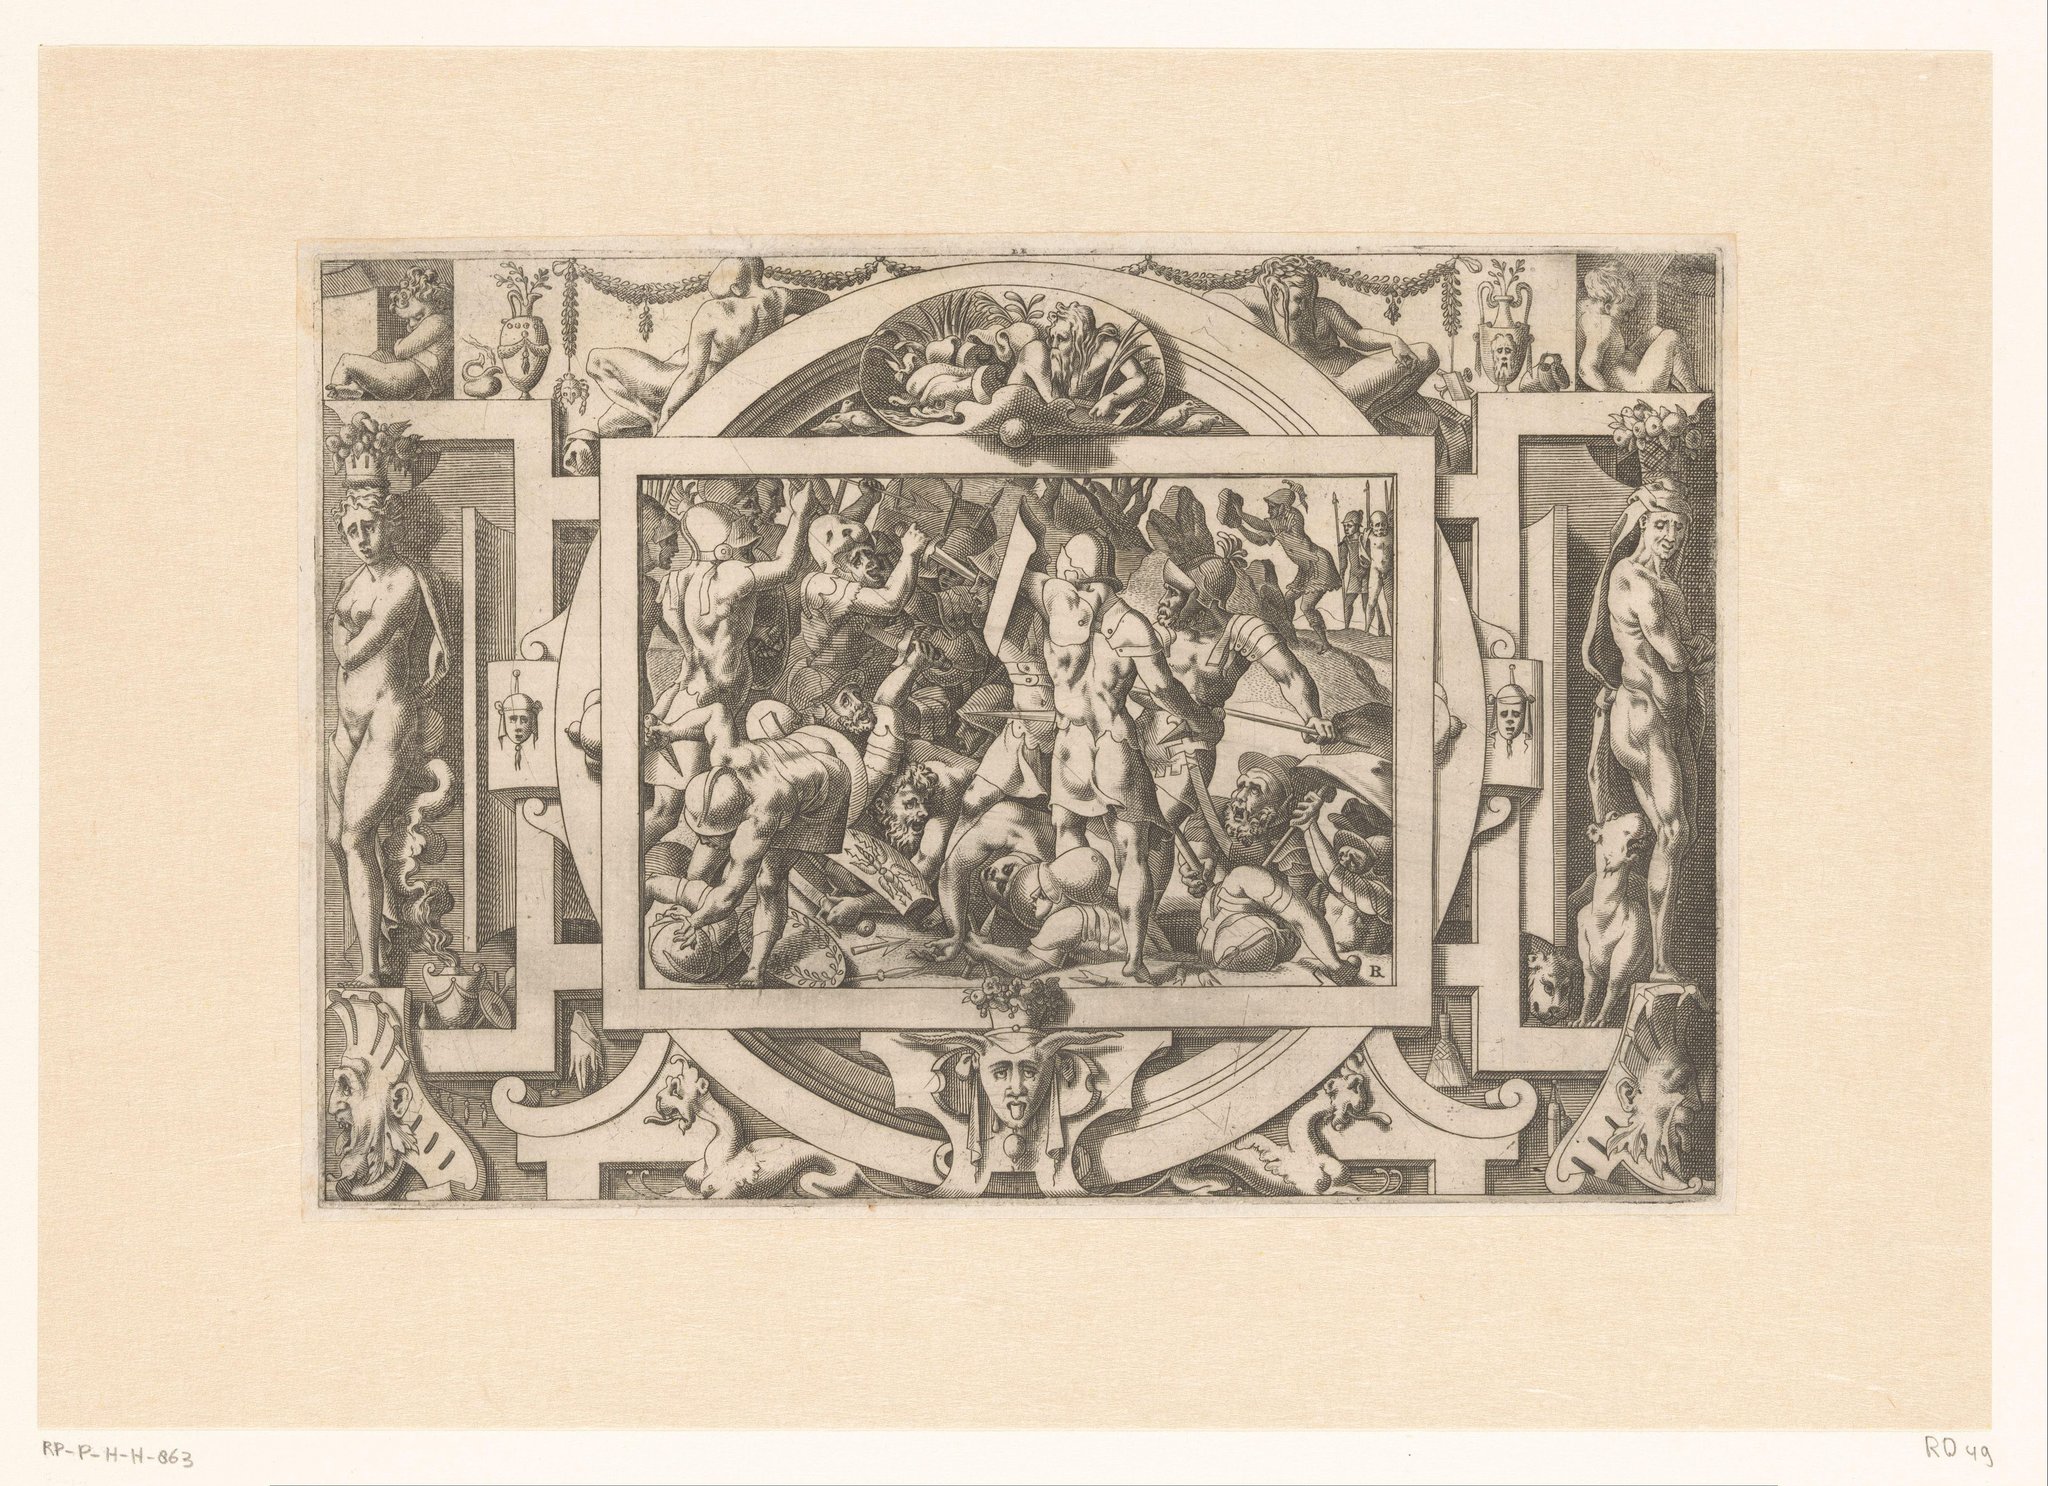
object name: print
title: Histoire de Jason et de la conquête de la toison d'or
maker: rené boyvin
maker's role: print maker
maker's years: 1525-1598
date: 1563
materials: paper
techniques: engraving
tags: after ploughing, jason sows dragon's teeth; armed men emerge, the dragon-men kill each other when jason throws a stone among them, the story of the argonauts: the quest for the golden fleece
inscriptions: collector's mark: Lugt 11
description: Maakt deel uit van een serie van 26 prenten met scènes uit het verhaal van Jason en het gulden vlies, uitgegeven in 1563 te Parijs.